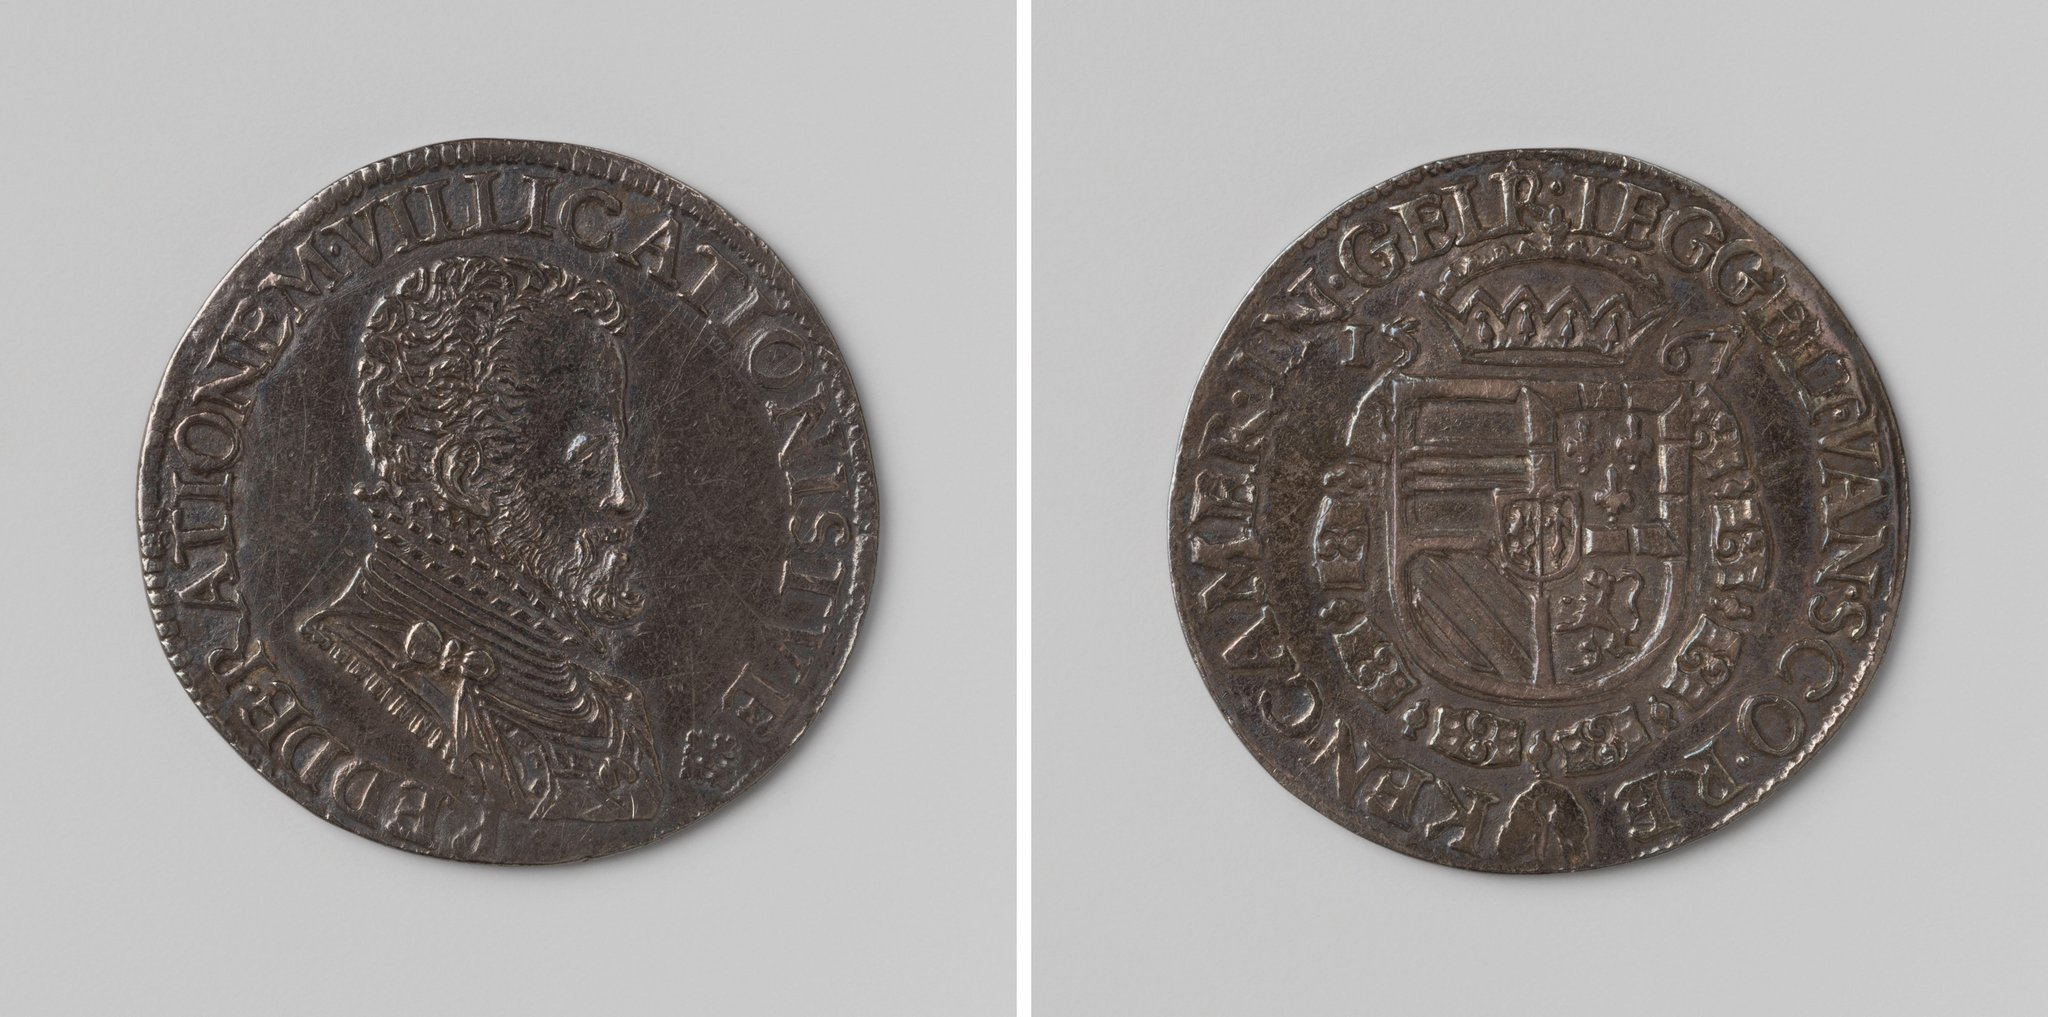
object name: jeton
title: Filips II, koning van Spanje, rekenpenning van de rekenkamer van Gelderland te Arnhem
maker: Anonymous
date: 1567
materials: silver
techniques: striking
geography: netherlands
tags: philip ii of spain, arnhem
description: Zilveren penning. Voorzijde: borststuk man binnen omschrift. Keerzijde: gekroond wapenschild omhangen met orde van Gulden Vlies tussen jaartal binnen omschrift